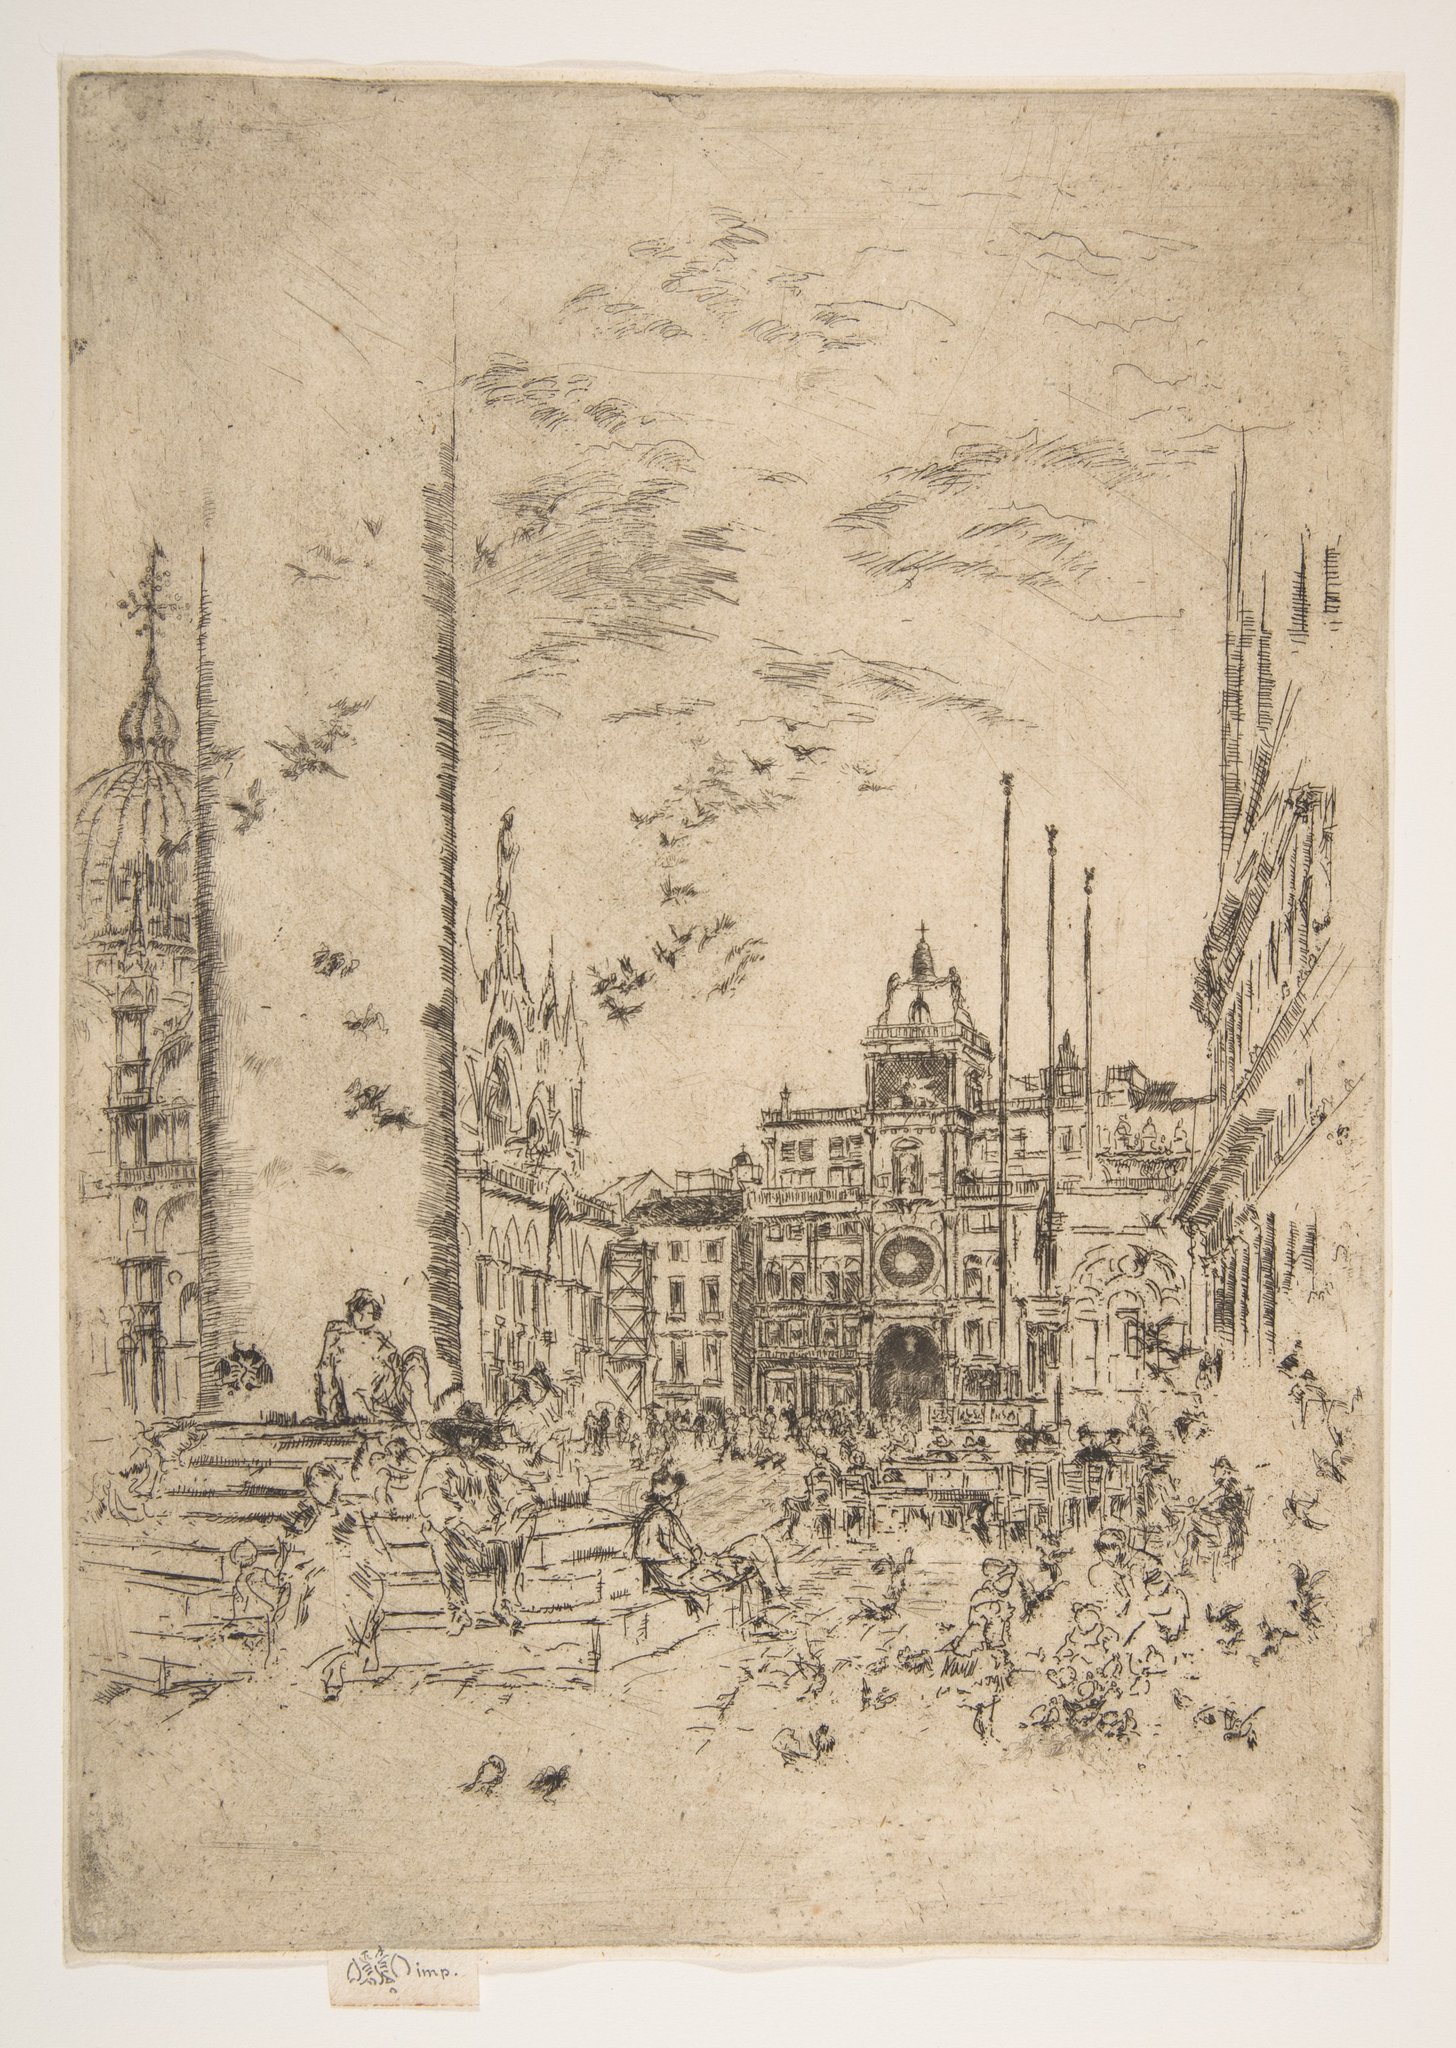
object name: print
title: The Piazetta (The Piazzetta)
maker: james mcneill whistler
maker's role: artist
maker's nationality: american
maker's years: 1834-1903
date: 1879-1880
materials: ink, paper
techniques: drypoint, etching, printing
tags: human figures,buildings,venice